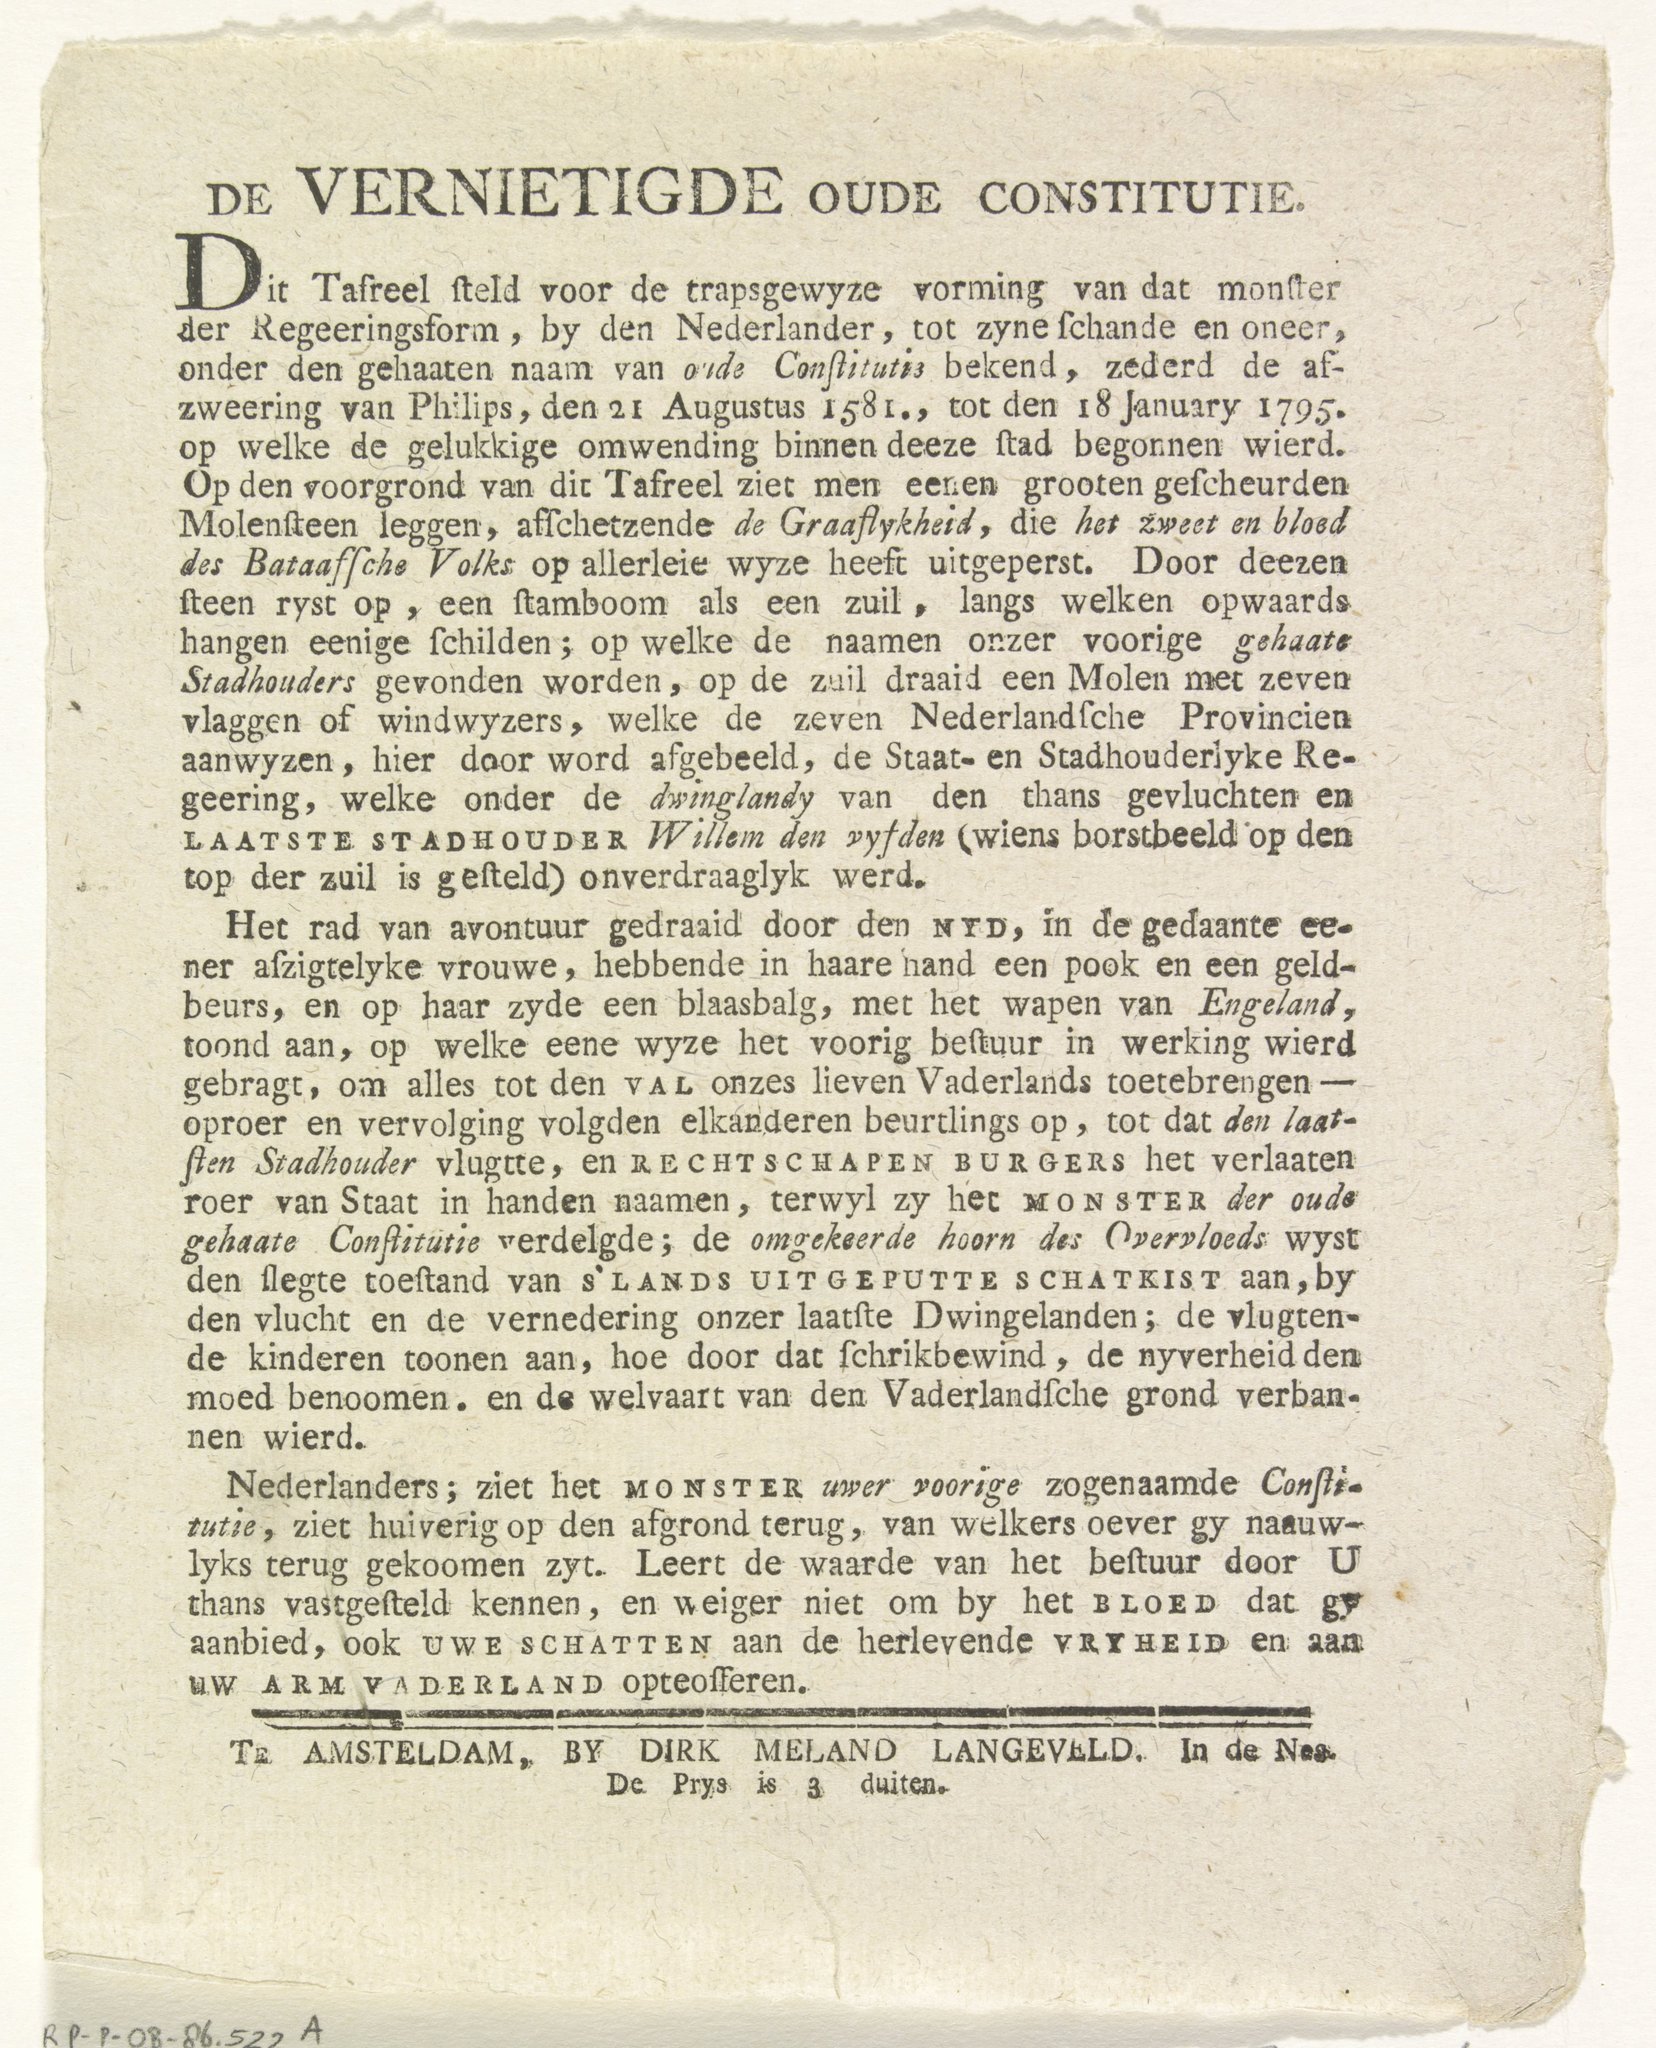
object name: text sheet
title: De Vernietiging van de Oude Constitutie, decoratie op de Botermarkt, 1795 (uitleg)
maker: dirk meland langeveld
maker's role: publisher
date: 1795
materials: paper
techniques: letterpress printing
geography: amsterdam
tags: amsterdam, alliance with france (1795)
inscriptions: collector's mark: Lugt 2228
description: Tekstblad met uitleg van de voorstelling van De Vernietiging van de Oude Constitutie, allegorische decoratie opgericht op de Botermarkt te Amsterdam. Waarschijnlijk behorend bij een afzonderlijke uitgave van de losse platen van de versieringen opgericht in de stad bij de viering van de installatie van de representanten en de alliantie gesloten tussen de Franse en de Bataafse Republiek, 19 juni 1795.